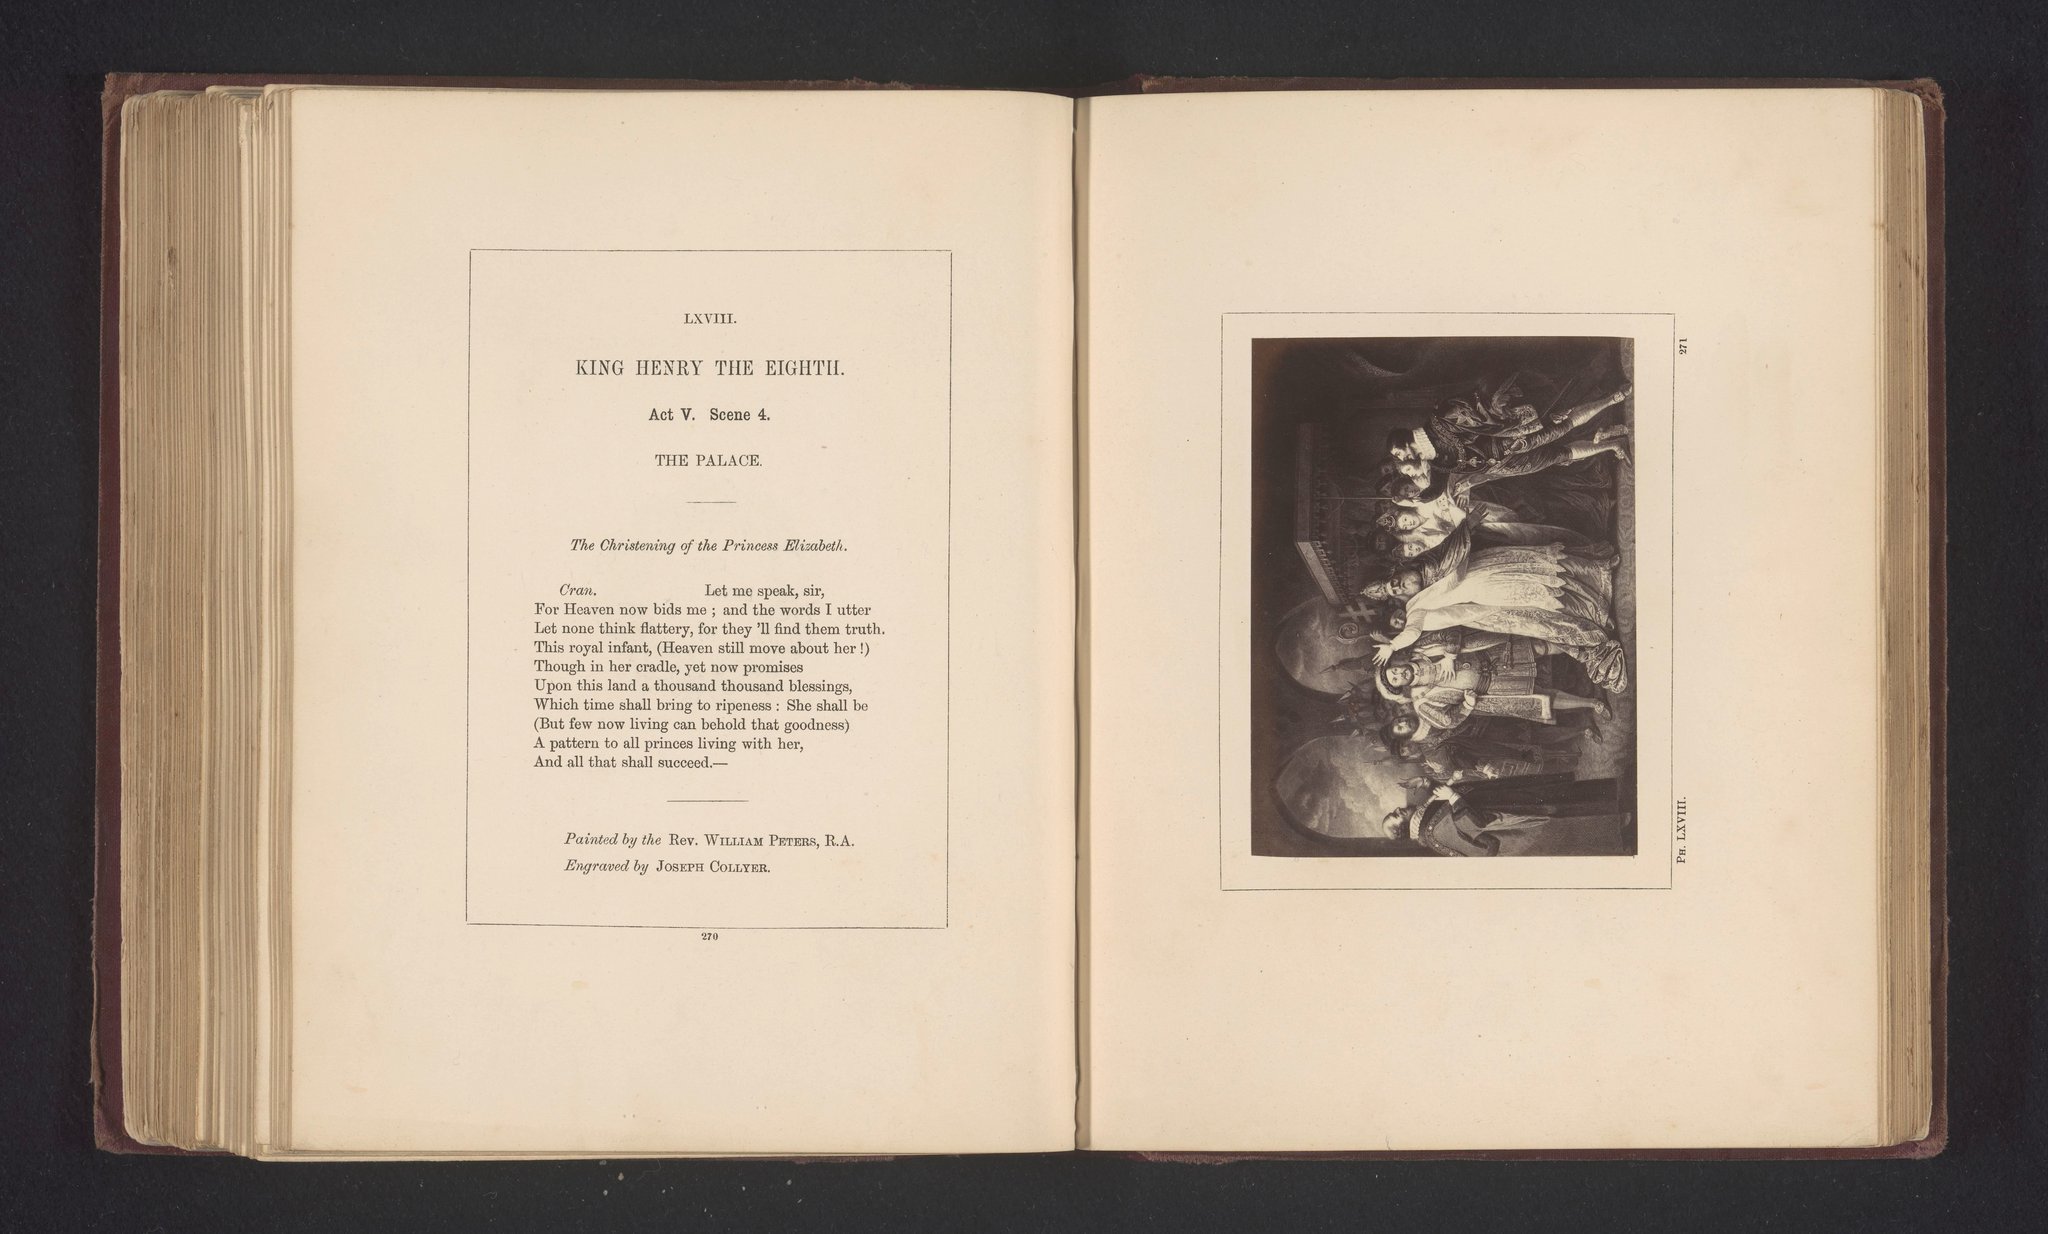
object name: photograph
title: Fotoreproductie van een prent naar een schilderij door Matthew William Peters, voorstellend een scene uit Hendrik VIII door William Shakespeare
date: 1854-1867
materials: photographic support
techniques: albumen print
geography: london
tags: specific works of literature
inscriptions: number: ‘Ph. LXVIII. 271’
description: Te zien is akte V, scene 4 met de doop van prinses Elizabeth.